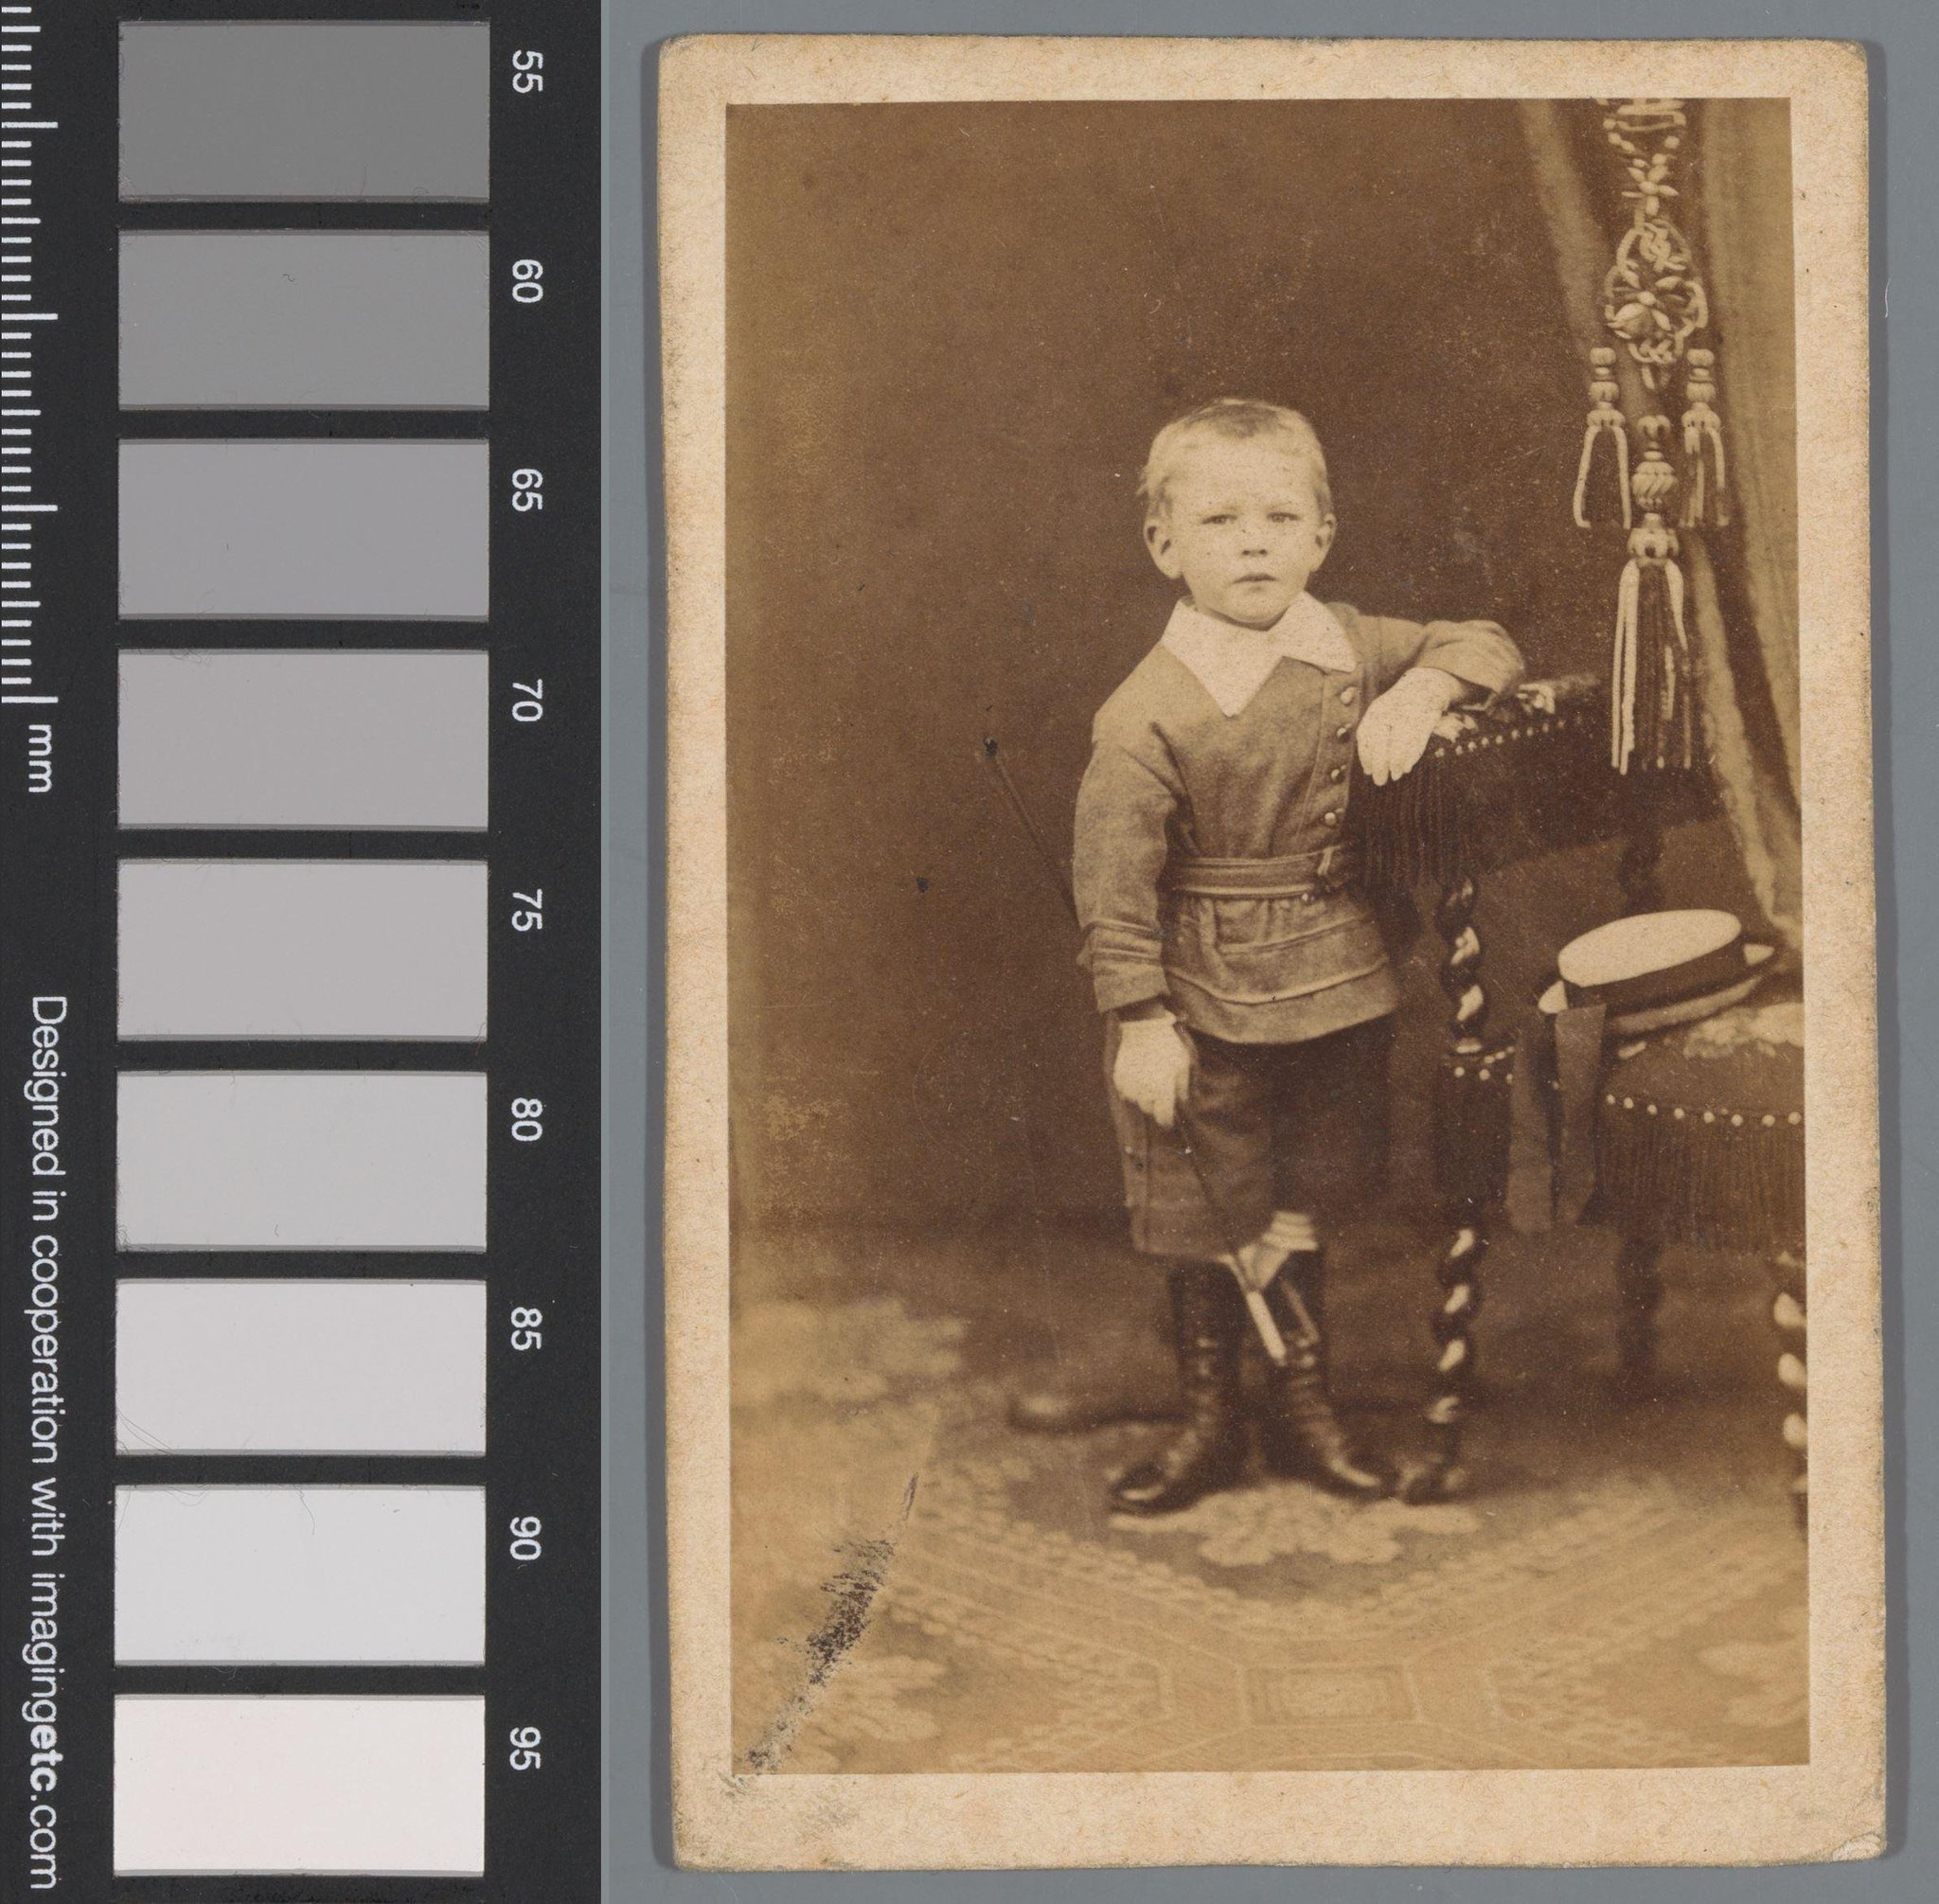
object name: photograph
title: Portret van een onbekende jongen naast een stoel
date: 1872-1878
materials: cardboard, paper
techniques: albumen print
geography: amsterdam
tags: boy (child between toddler and youth), anonymous historical person portrayed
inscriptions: address: ‘Egelantiersgracht bij de Baangracht NN. 86./ AMSTERDAM.’, inscription: ‘Reproductie./ Stadsgezichten./ Photominiatur./ Groote Portretten enz./ De plaat blijft tot nabestelling bewaard.’